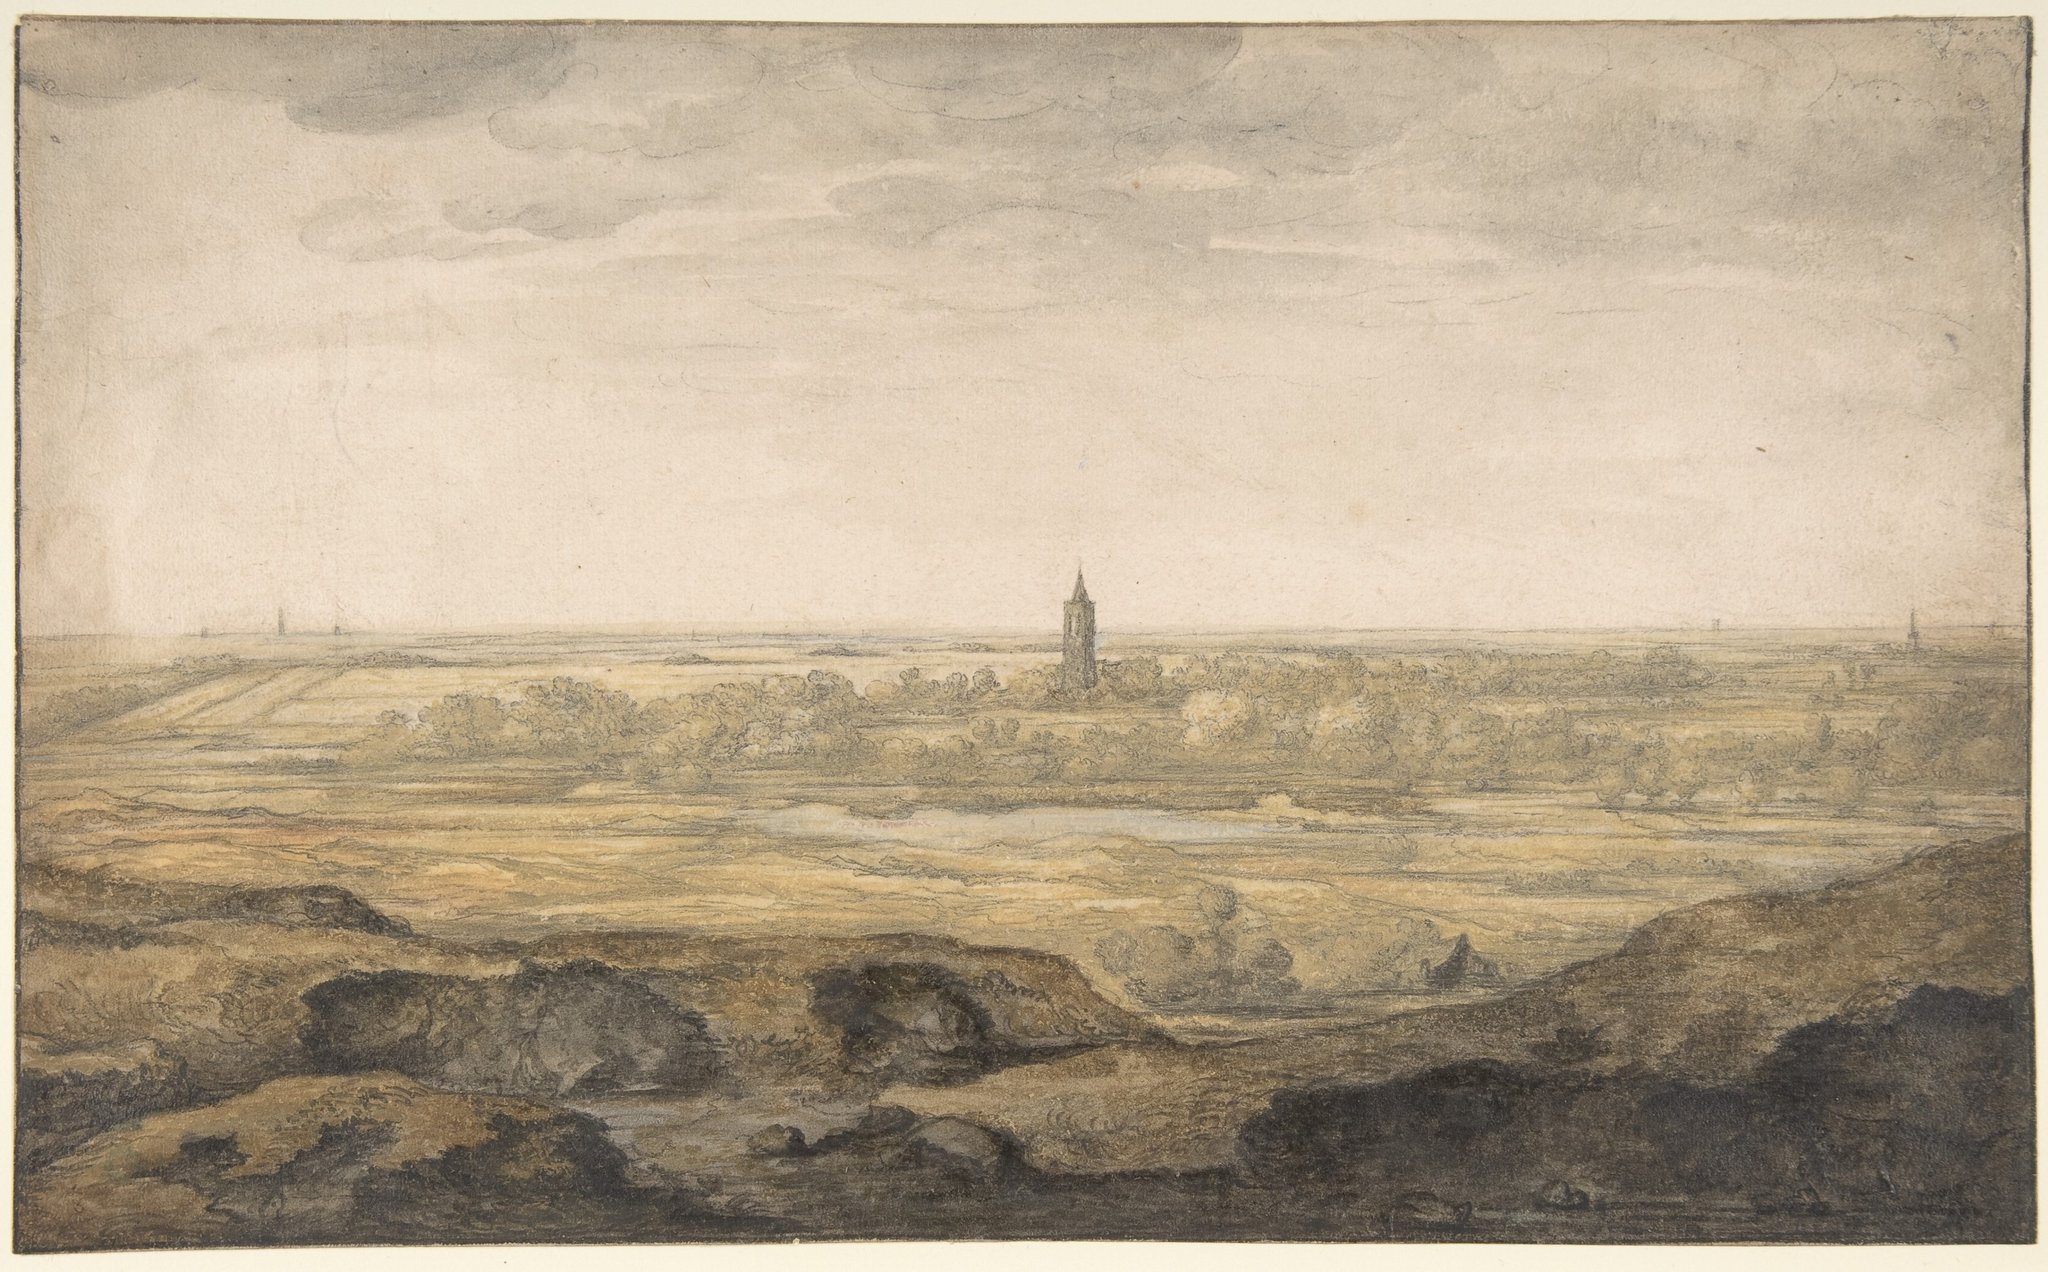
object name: drawing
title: Landscape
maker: aelbert cuyp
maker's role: artist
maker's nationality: dutch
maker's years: 1620-1691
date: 1635-1691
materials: chalk, gouache, watercolor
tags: towers,landscapes